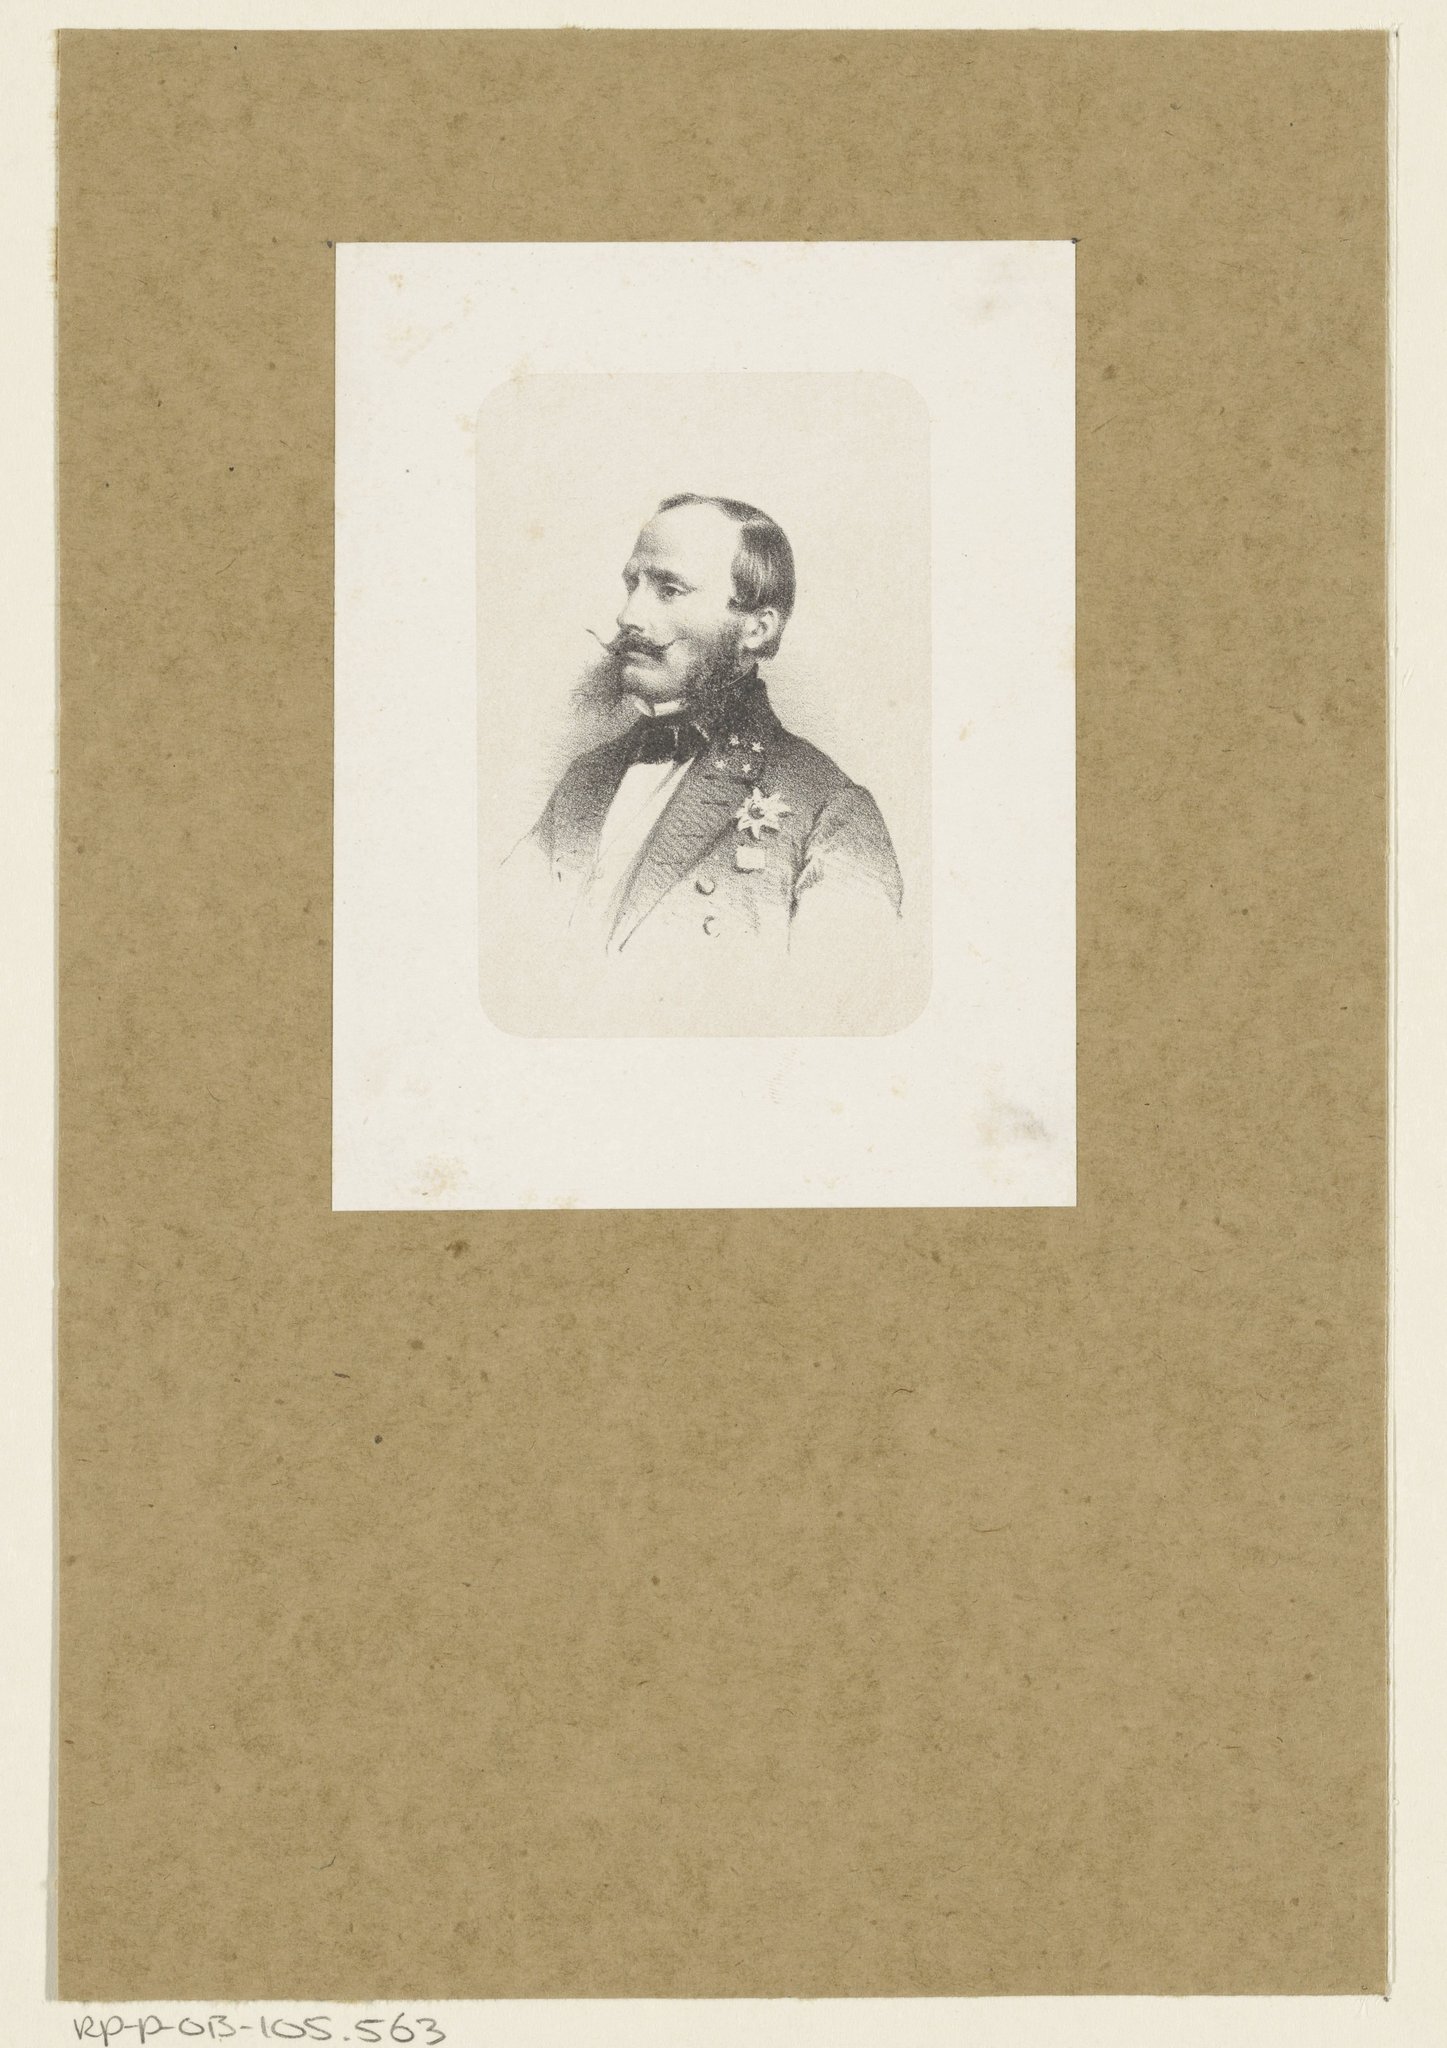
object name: print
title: Portret van Hendrik, prins der Nederlanden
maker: Anonymous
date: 1850-1949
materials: paper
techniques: lithograph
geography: netherlands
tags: hendrik (prins der nederlanden)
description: De hier vermelde titel verwijst naar de hoogst verkregen titel van de geportretteerde, niet per se naar de titel die de geportretteerde op deze voorstelling draagt.